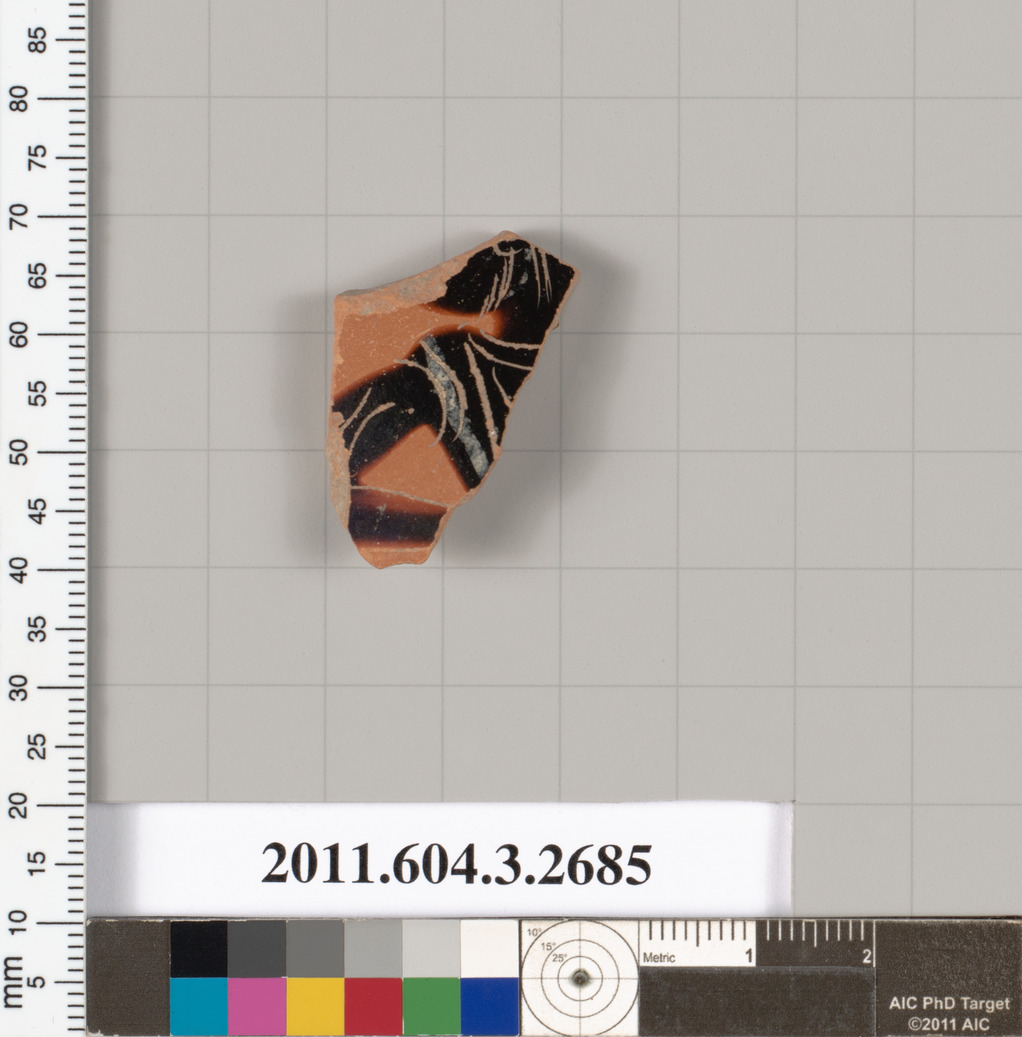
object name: oinochoe fragment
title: Terracotta fragment of an oinochoe (jug)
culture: greek, attic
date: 510-500 BCE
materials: terracotta